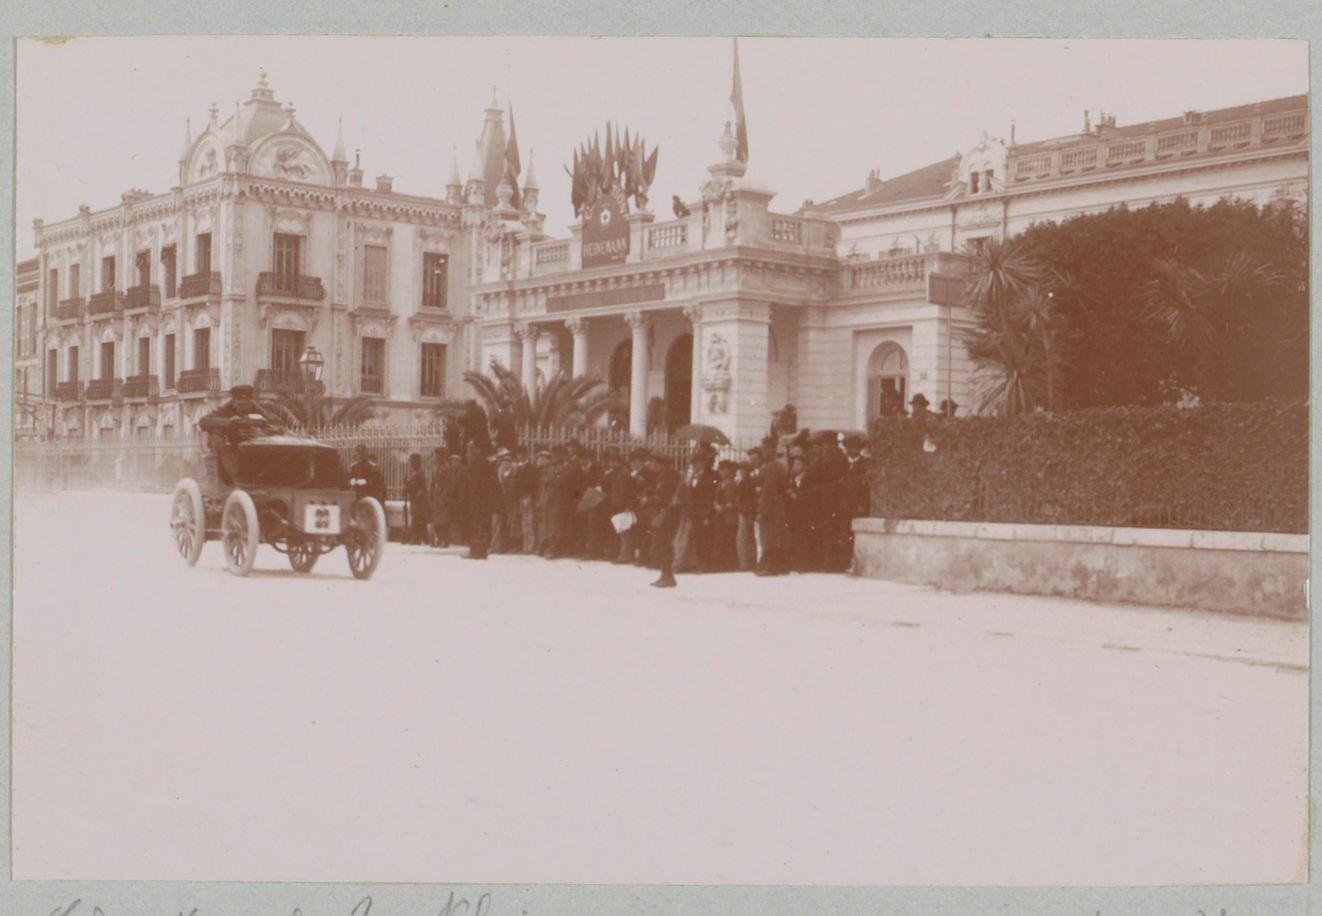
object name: photograph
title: Autocoureur De Burkheim, deelnemer aan de Course du Mille, een race voor automobielen in Nice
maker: delizy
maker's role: manufacturer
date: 1899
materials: paper, photographic support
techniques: gelatin silver print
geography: nice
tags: motorcar racing, automobile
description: Onderdeel van Fotoalbum van een Franse amateurfotograaf met opnames van uitstapjes in Frankrijk, Spanje, België, Luxemburg en Nederland, de eerste automobielen en autoraces.